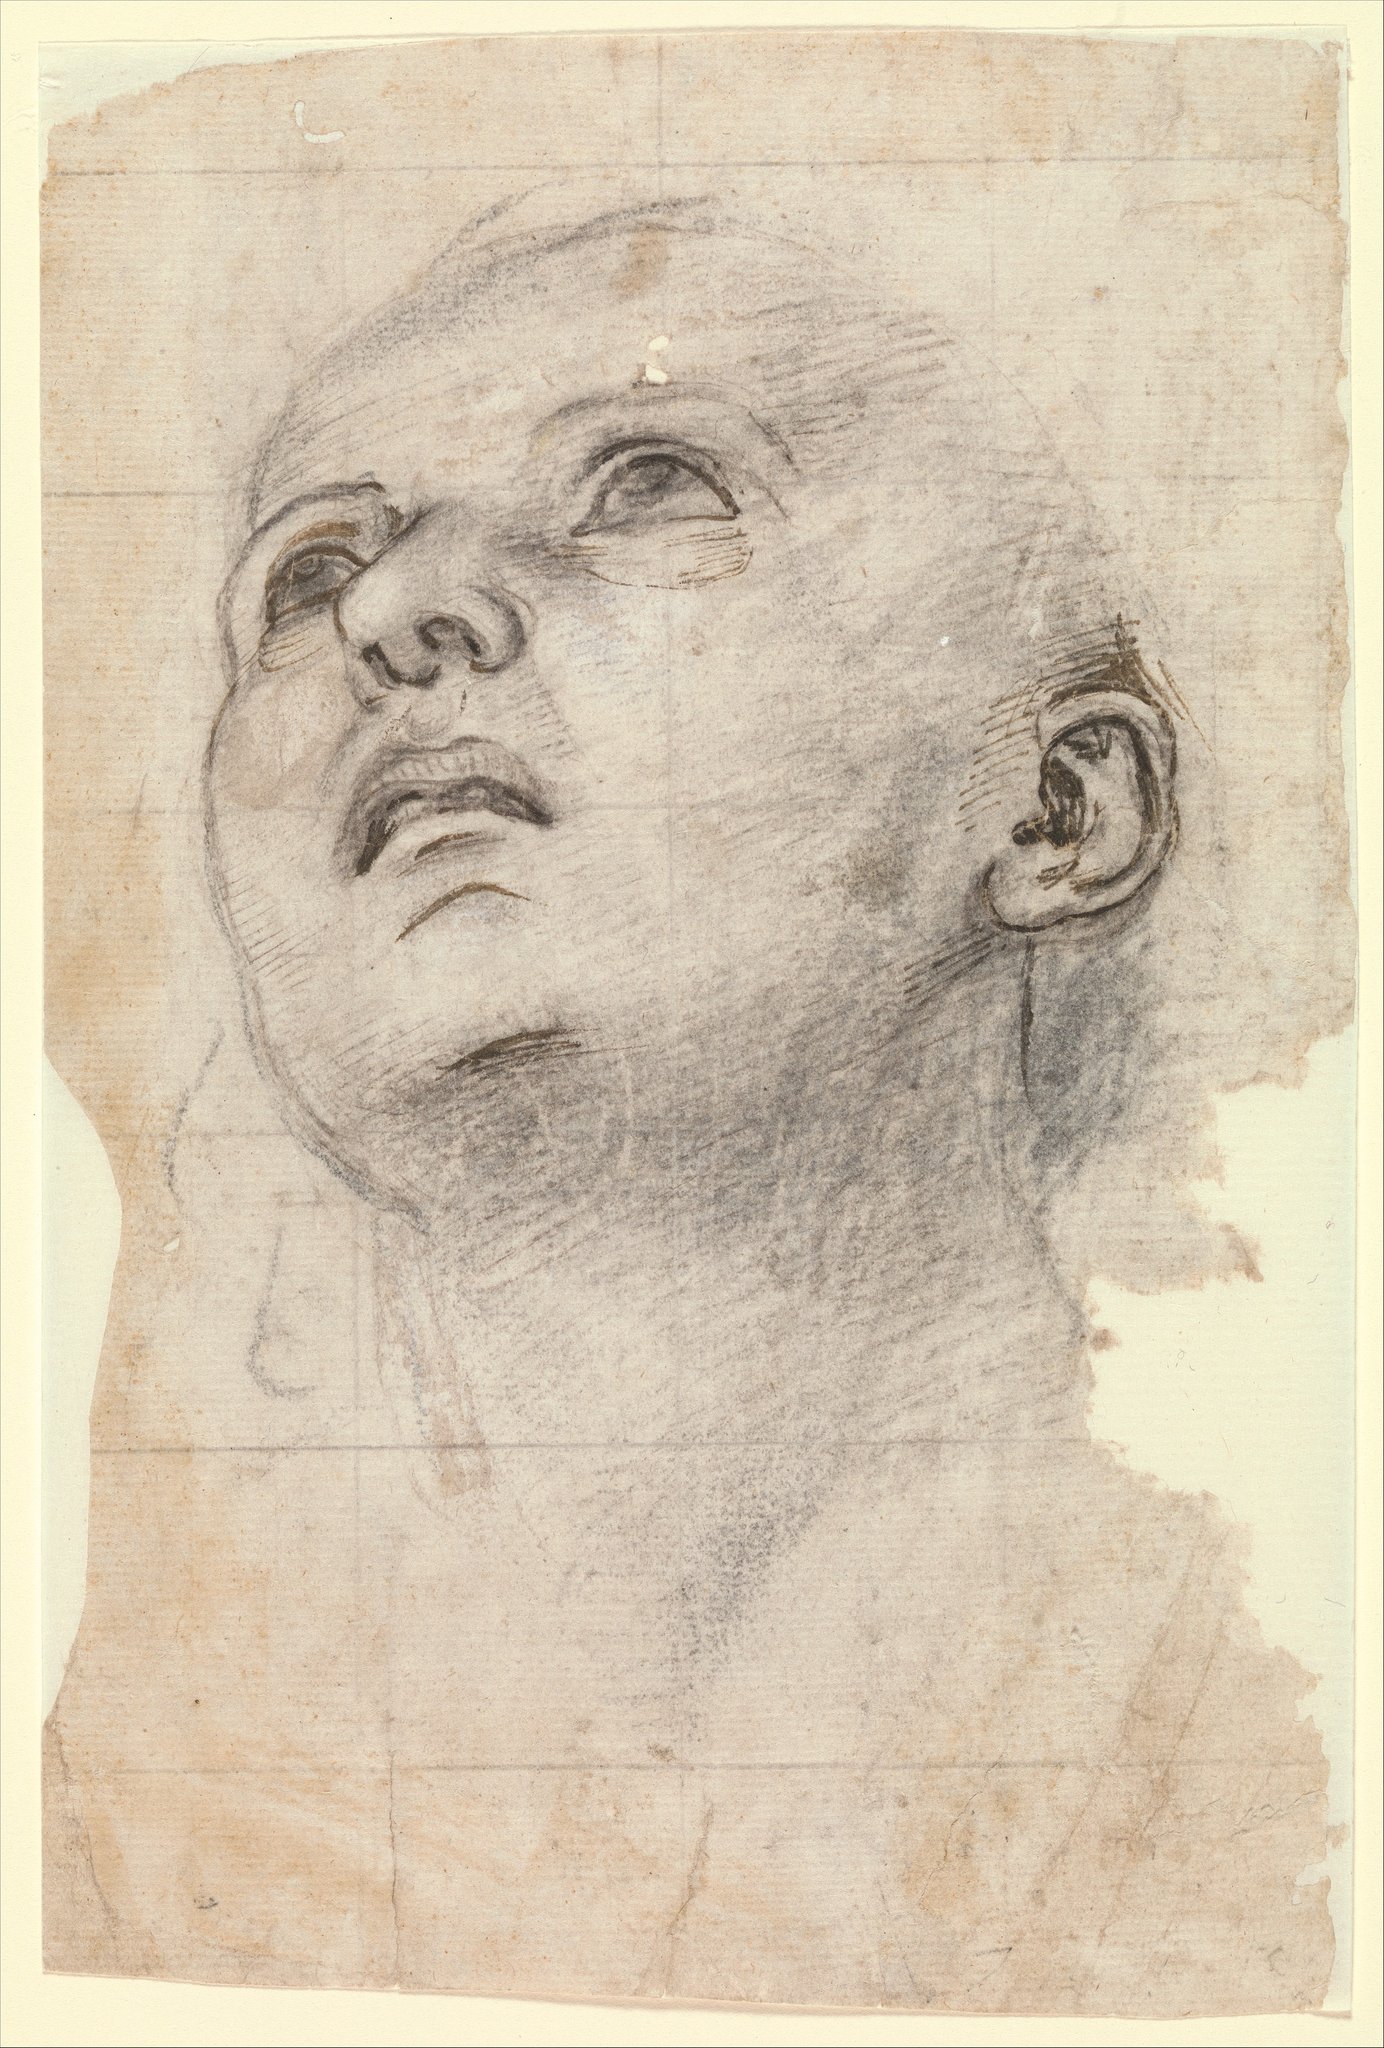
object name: drawing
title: Study of the Head of a Youth Gazing Upward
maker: perugino (pietro di cristoforo vannucci)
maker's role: artist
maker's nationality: italian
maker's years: 1469-1523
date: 1467-1533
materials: chalk, ink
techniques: pen, drawing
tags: heads,men